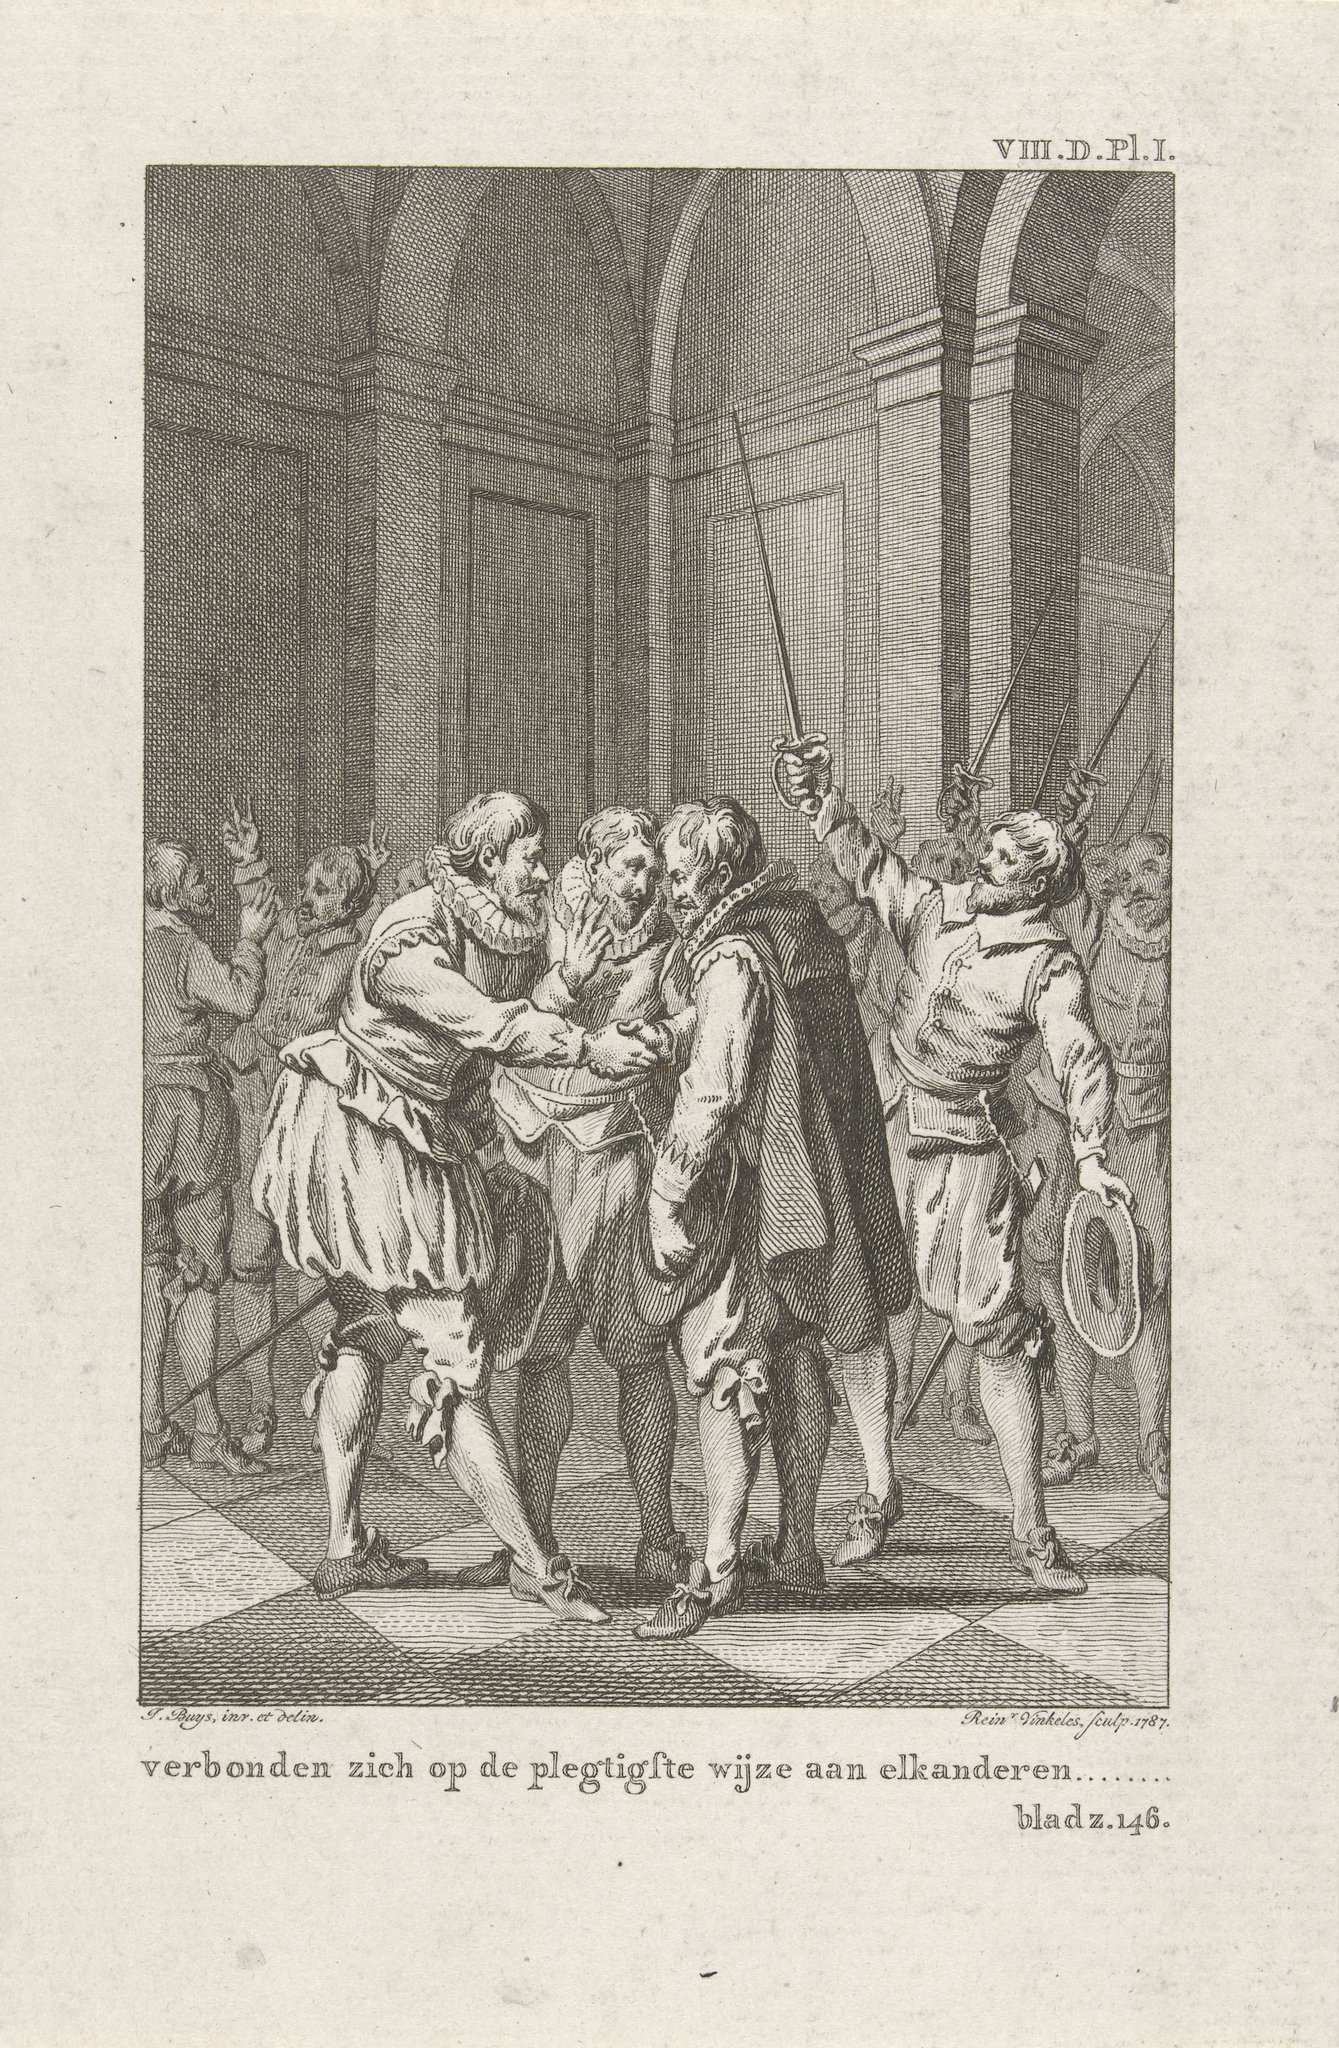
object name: history print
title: Het verbond der edelen, 1565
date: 1787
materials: paper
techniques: etching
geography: netherlands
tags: alliance, league, union, foedus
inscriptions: date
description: Het verbond der edelen op het kasteel van Hendrik van Brederode te Vianen, 1565.